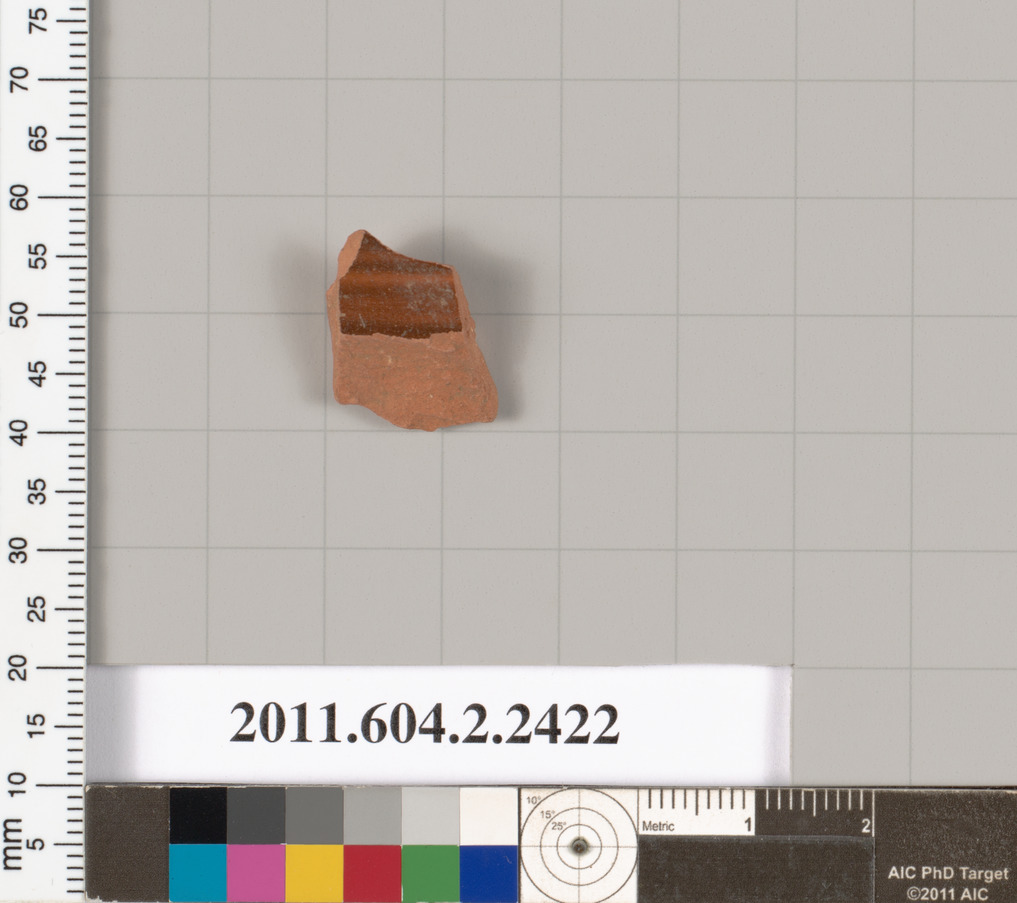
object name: undetermined closed shape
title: Terracotta fragment of a closed shape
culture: greek, attic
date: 600-401 BCE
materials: terracotta